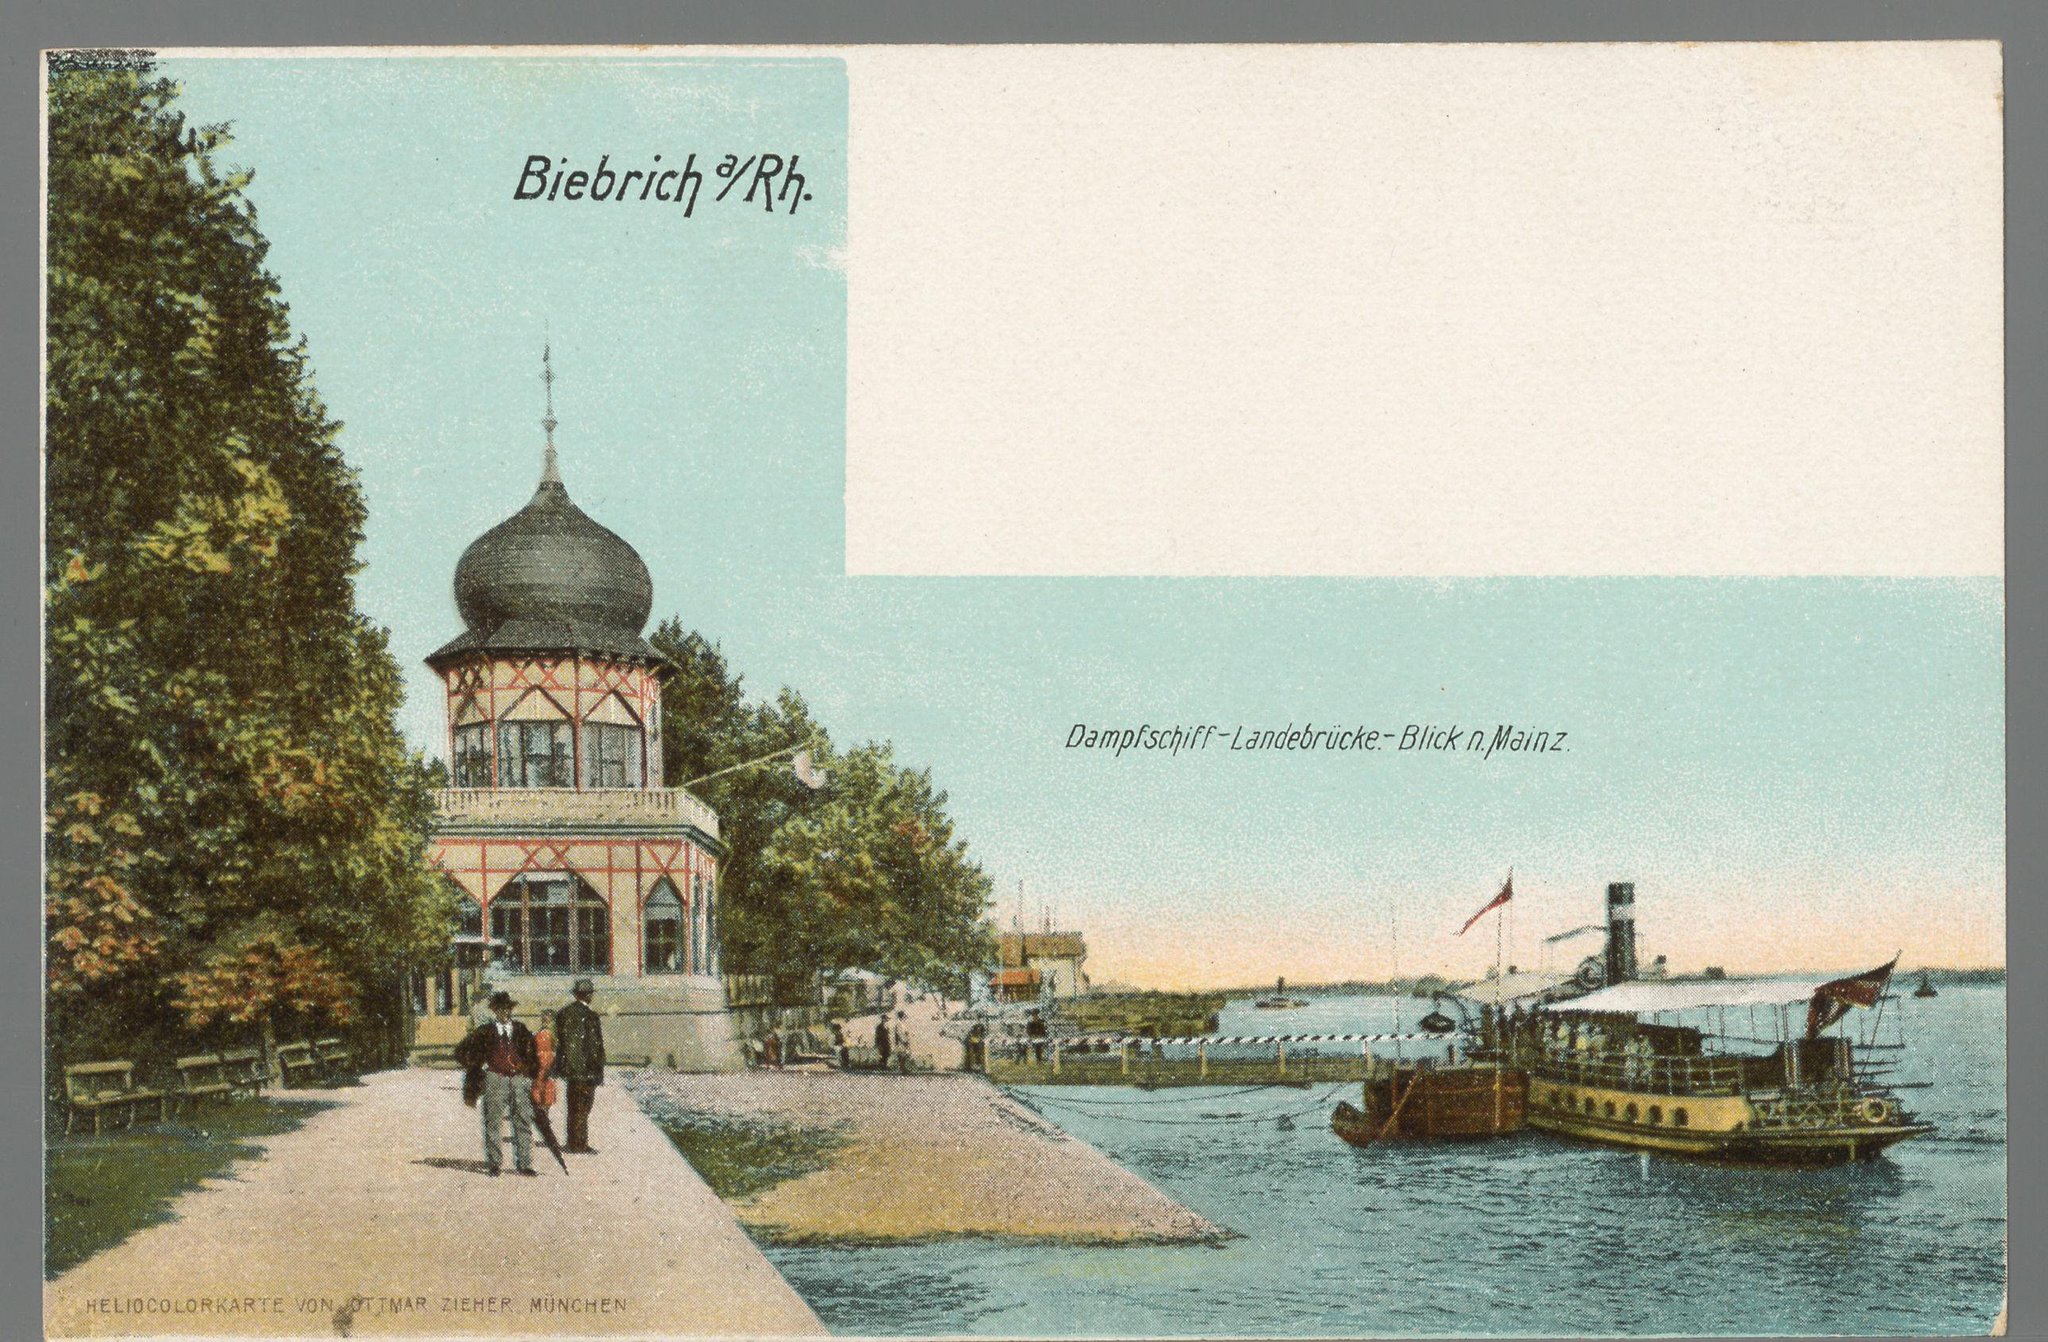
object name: photomechanical print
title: Biebrich a/Rh. Dampfschiff-Landebrücke.-Blick n. Mainz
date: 1900-1905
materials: cardboard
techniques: lithograph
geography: munich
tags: river, steamship, motorship